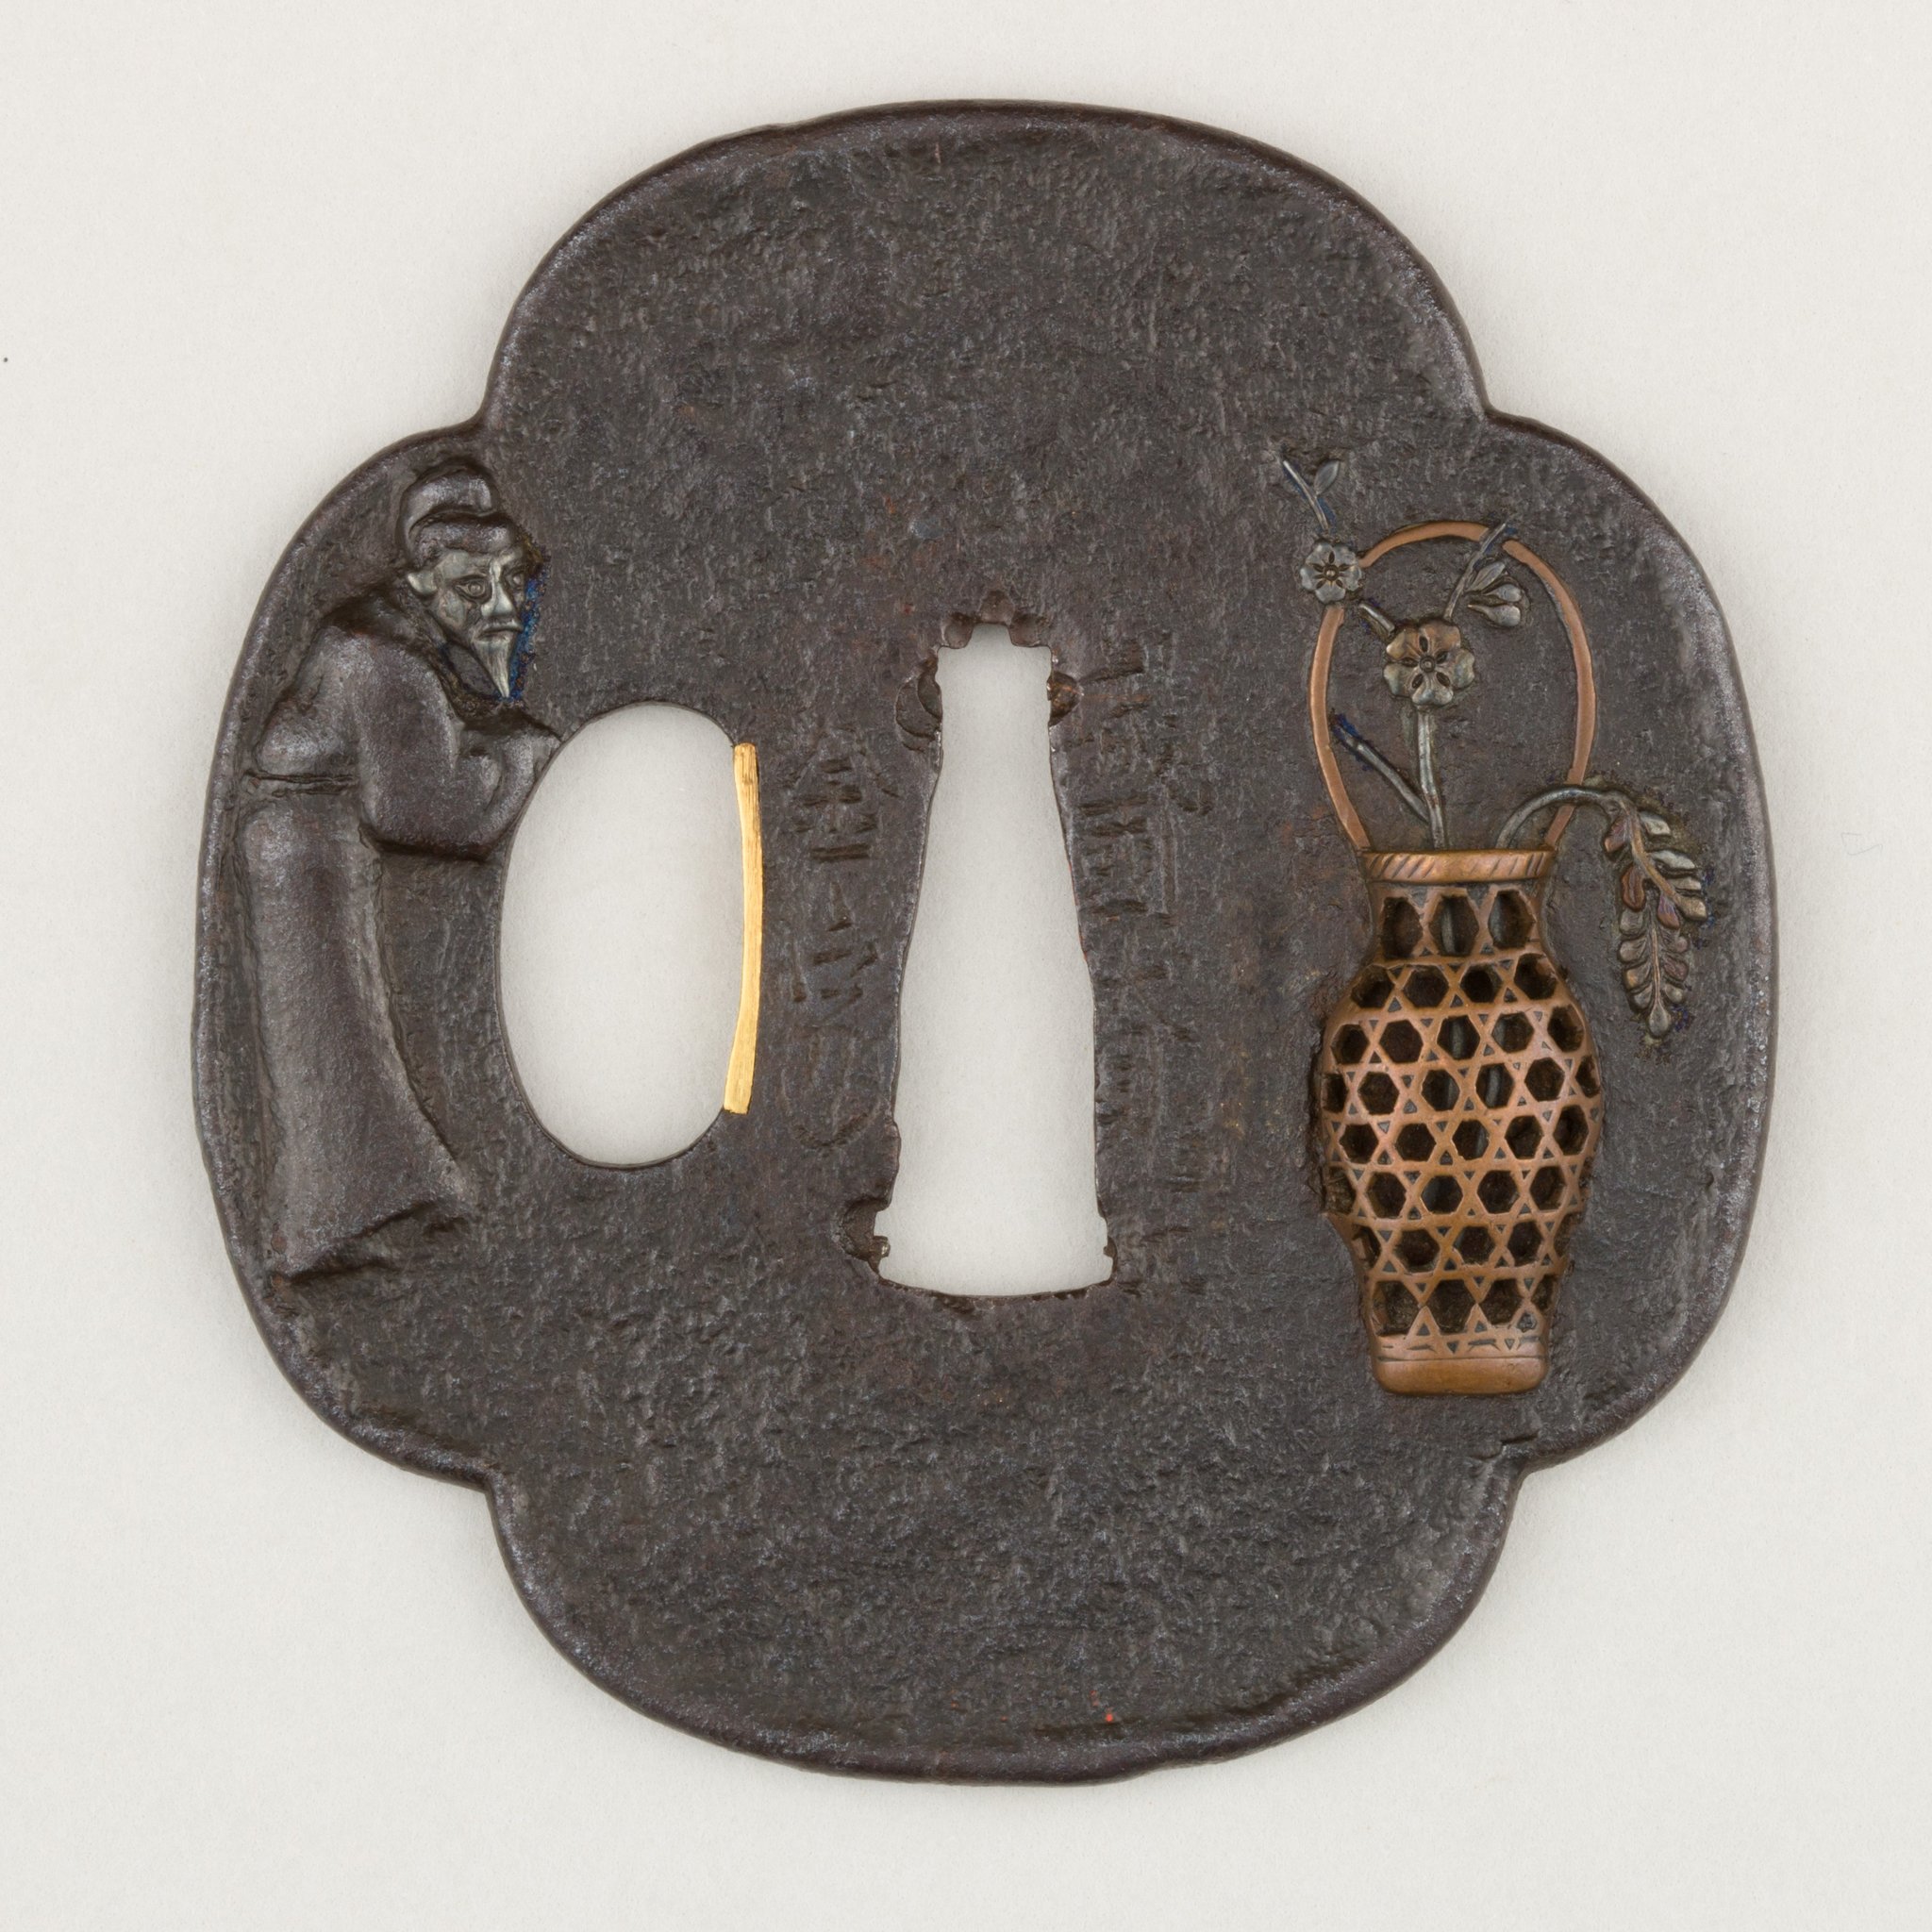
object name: sword guard tsuba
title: Sword Guard (Tsuba)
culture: japanese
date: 1501-1600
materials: copper, iron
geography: japan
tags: men,flowers,vases